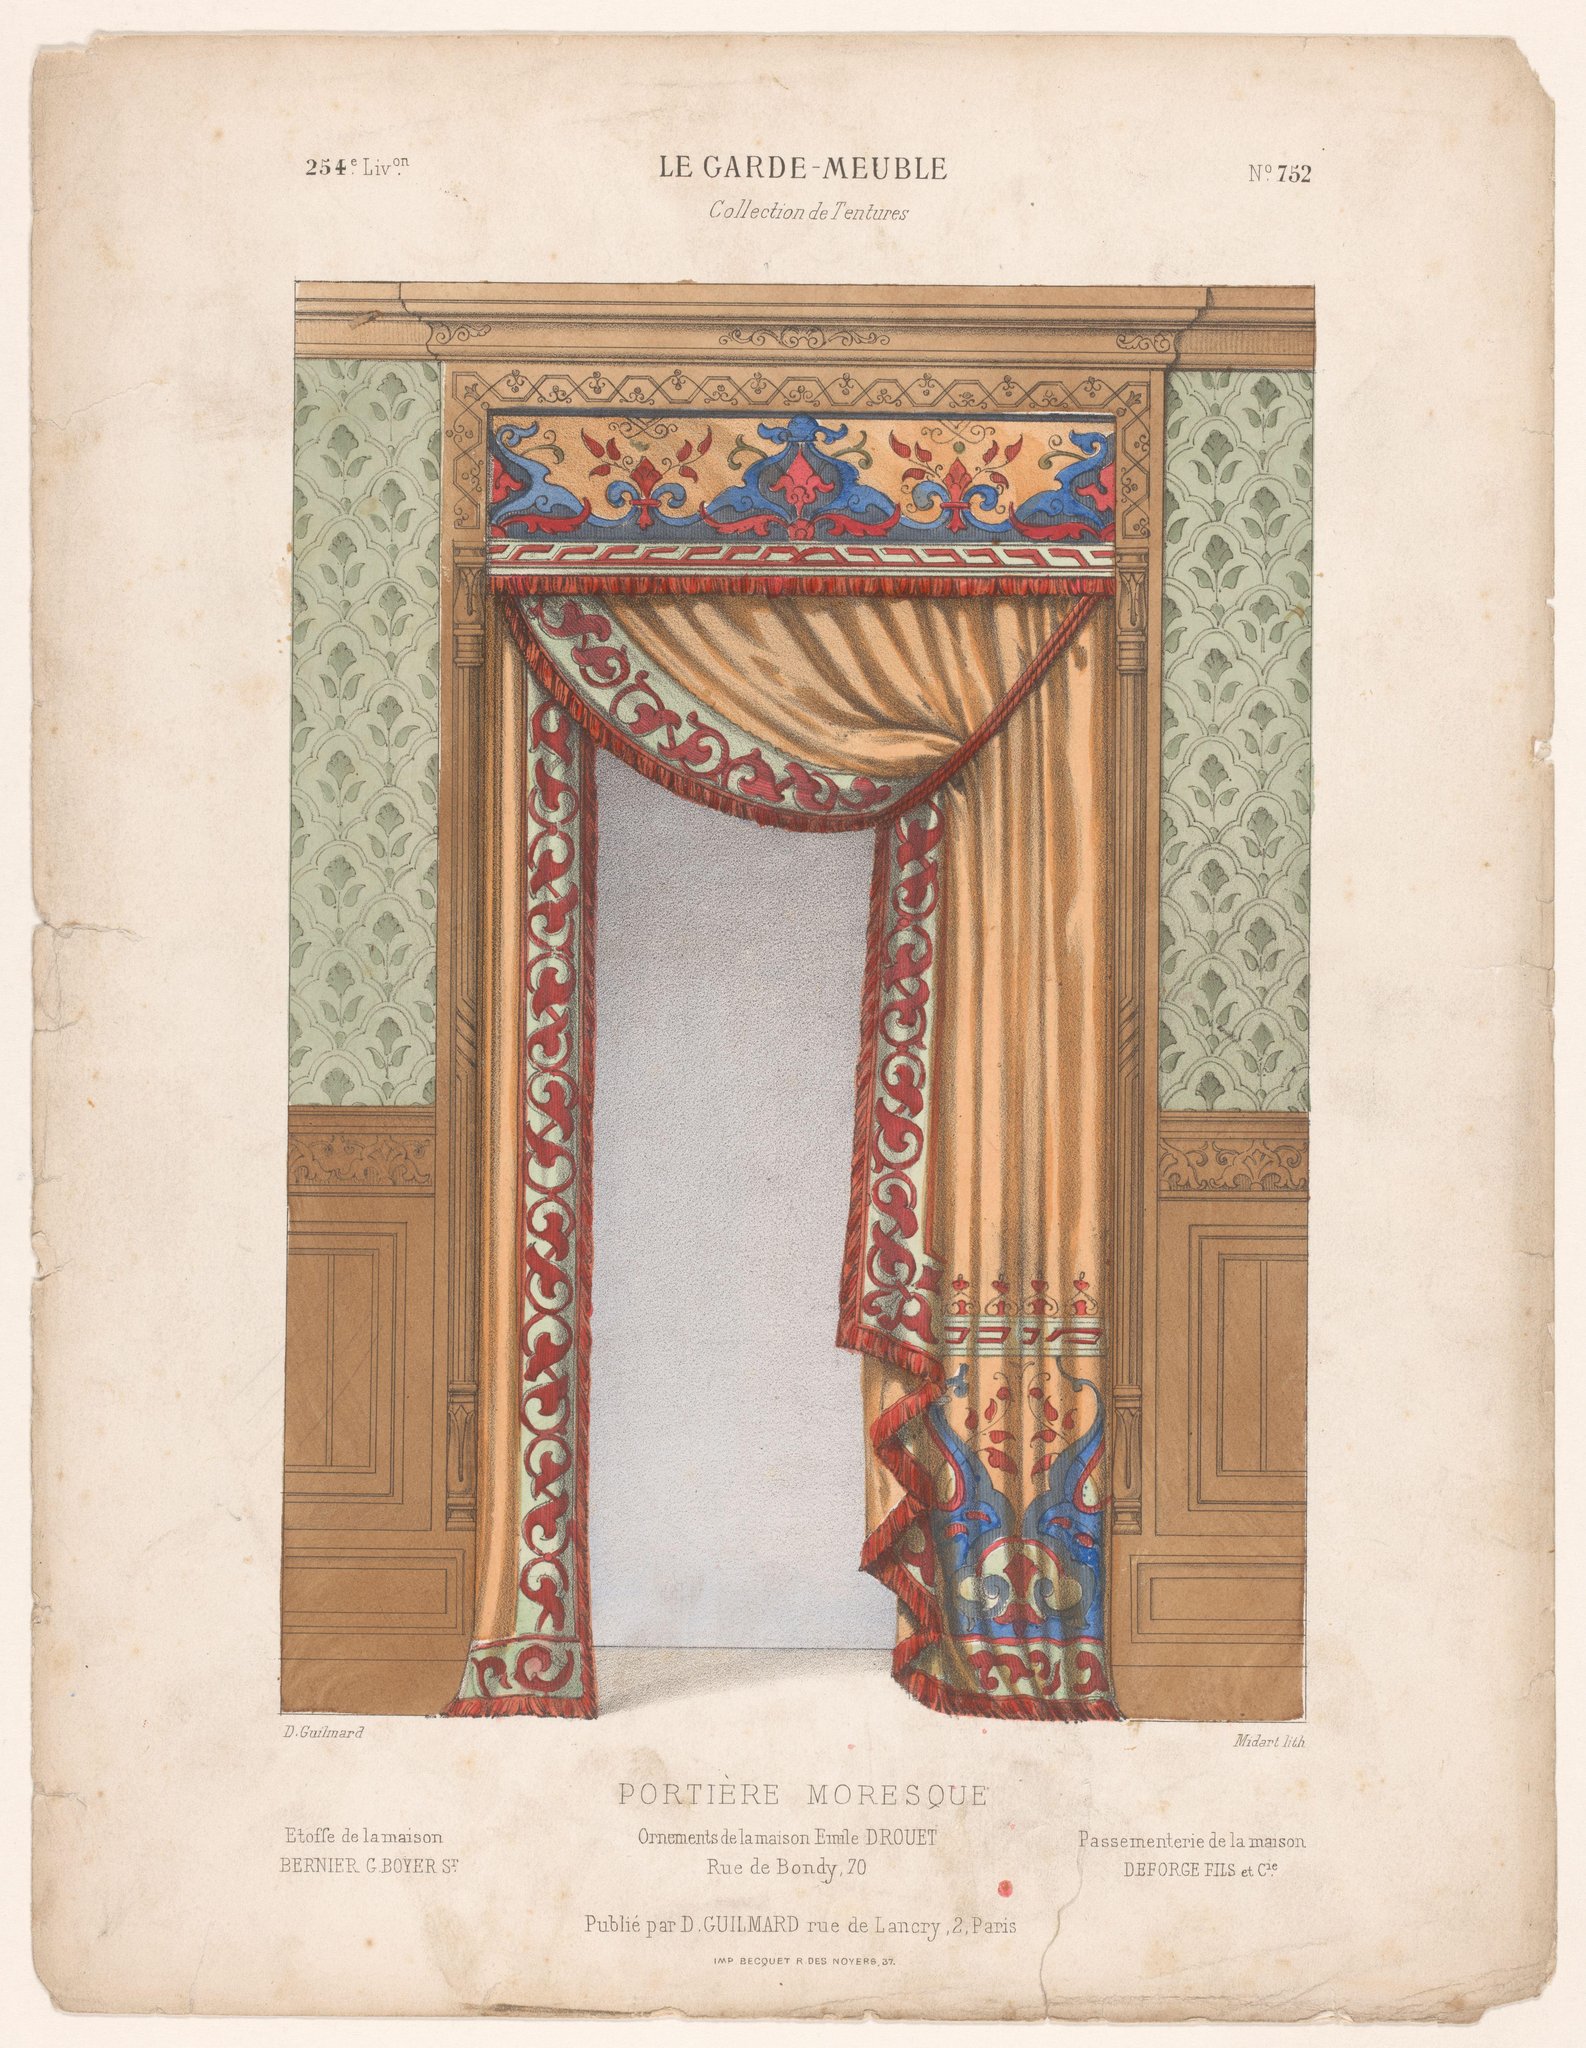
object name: print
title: Deur met gordijnen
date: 1860-1880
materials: paper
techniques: hand coloring, lithograph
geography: paris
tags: door, hangings and drapery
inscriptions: annotation: ‘Vitrages f 28,= (...)’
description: Deur met gedrapeerde gordijnen in Moorse stijl. Prent uit 254e Livraison.